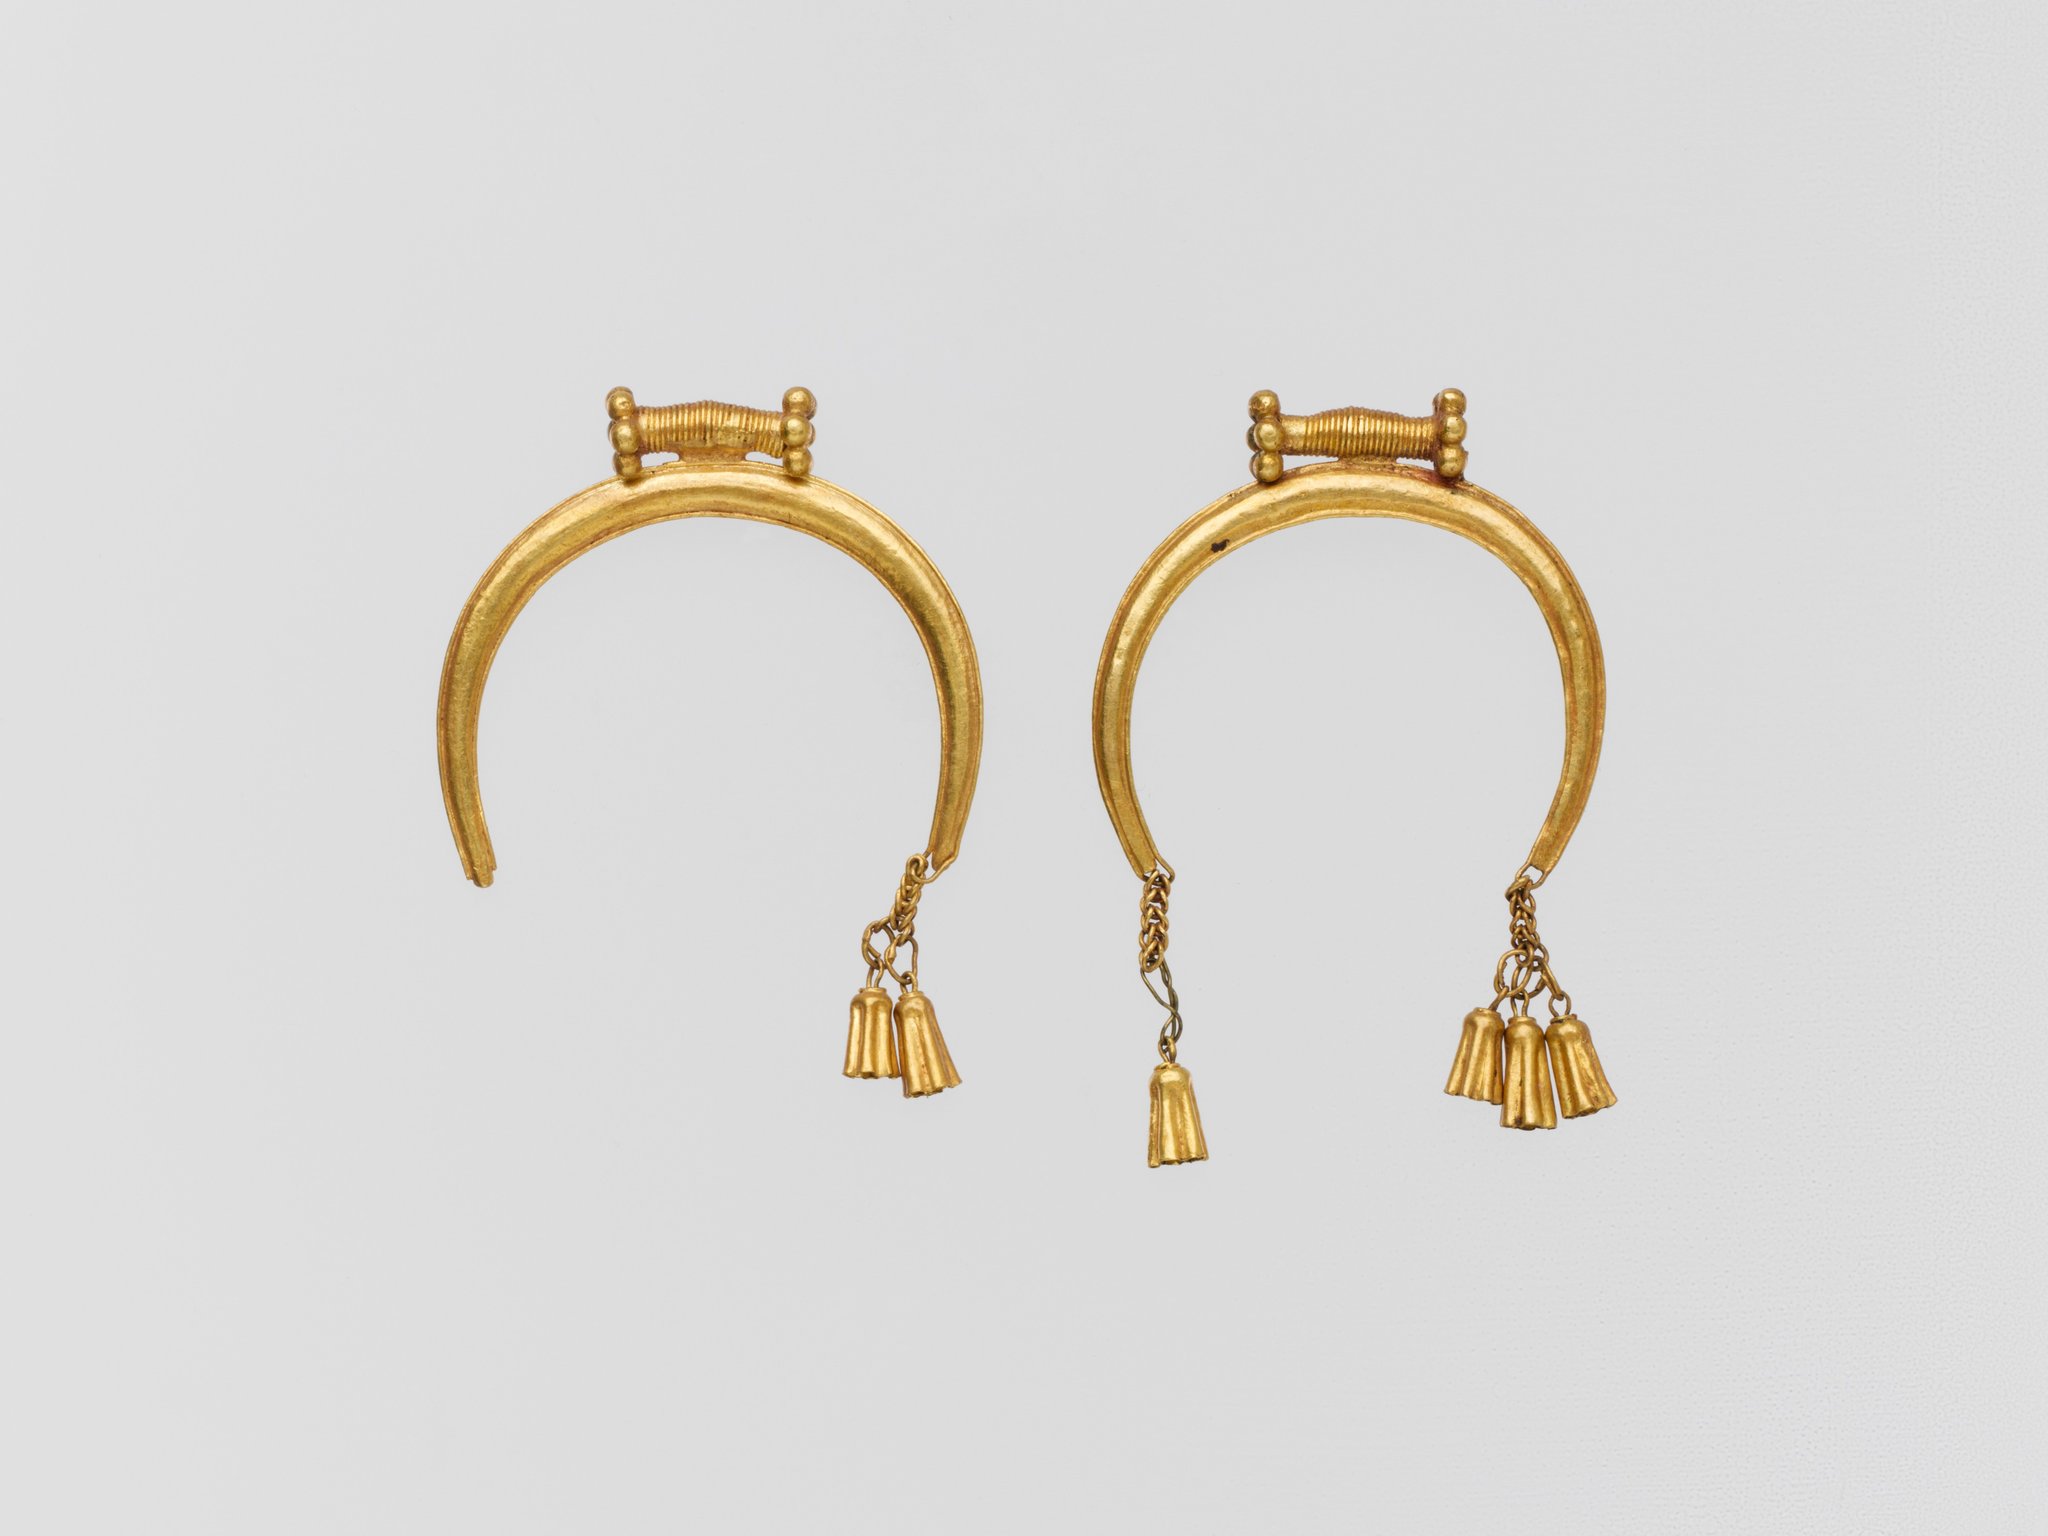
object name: pendant in the form of bell shaped flower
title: Gold pendant with tassels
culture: cypriot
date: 700-501 BCE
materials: gold